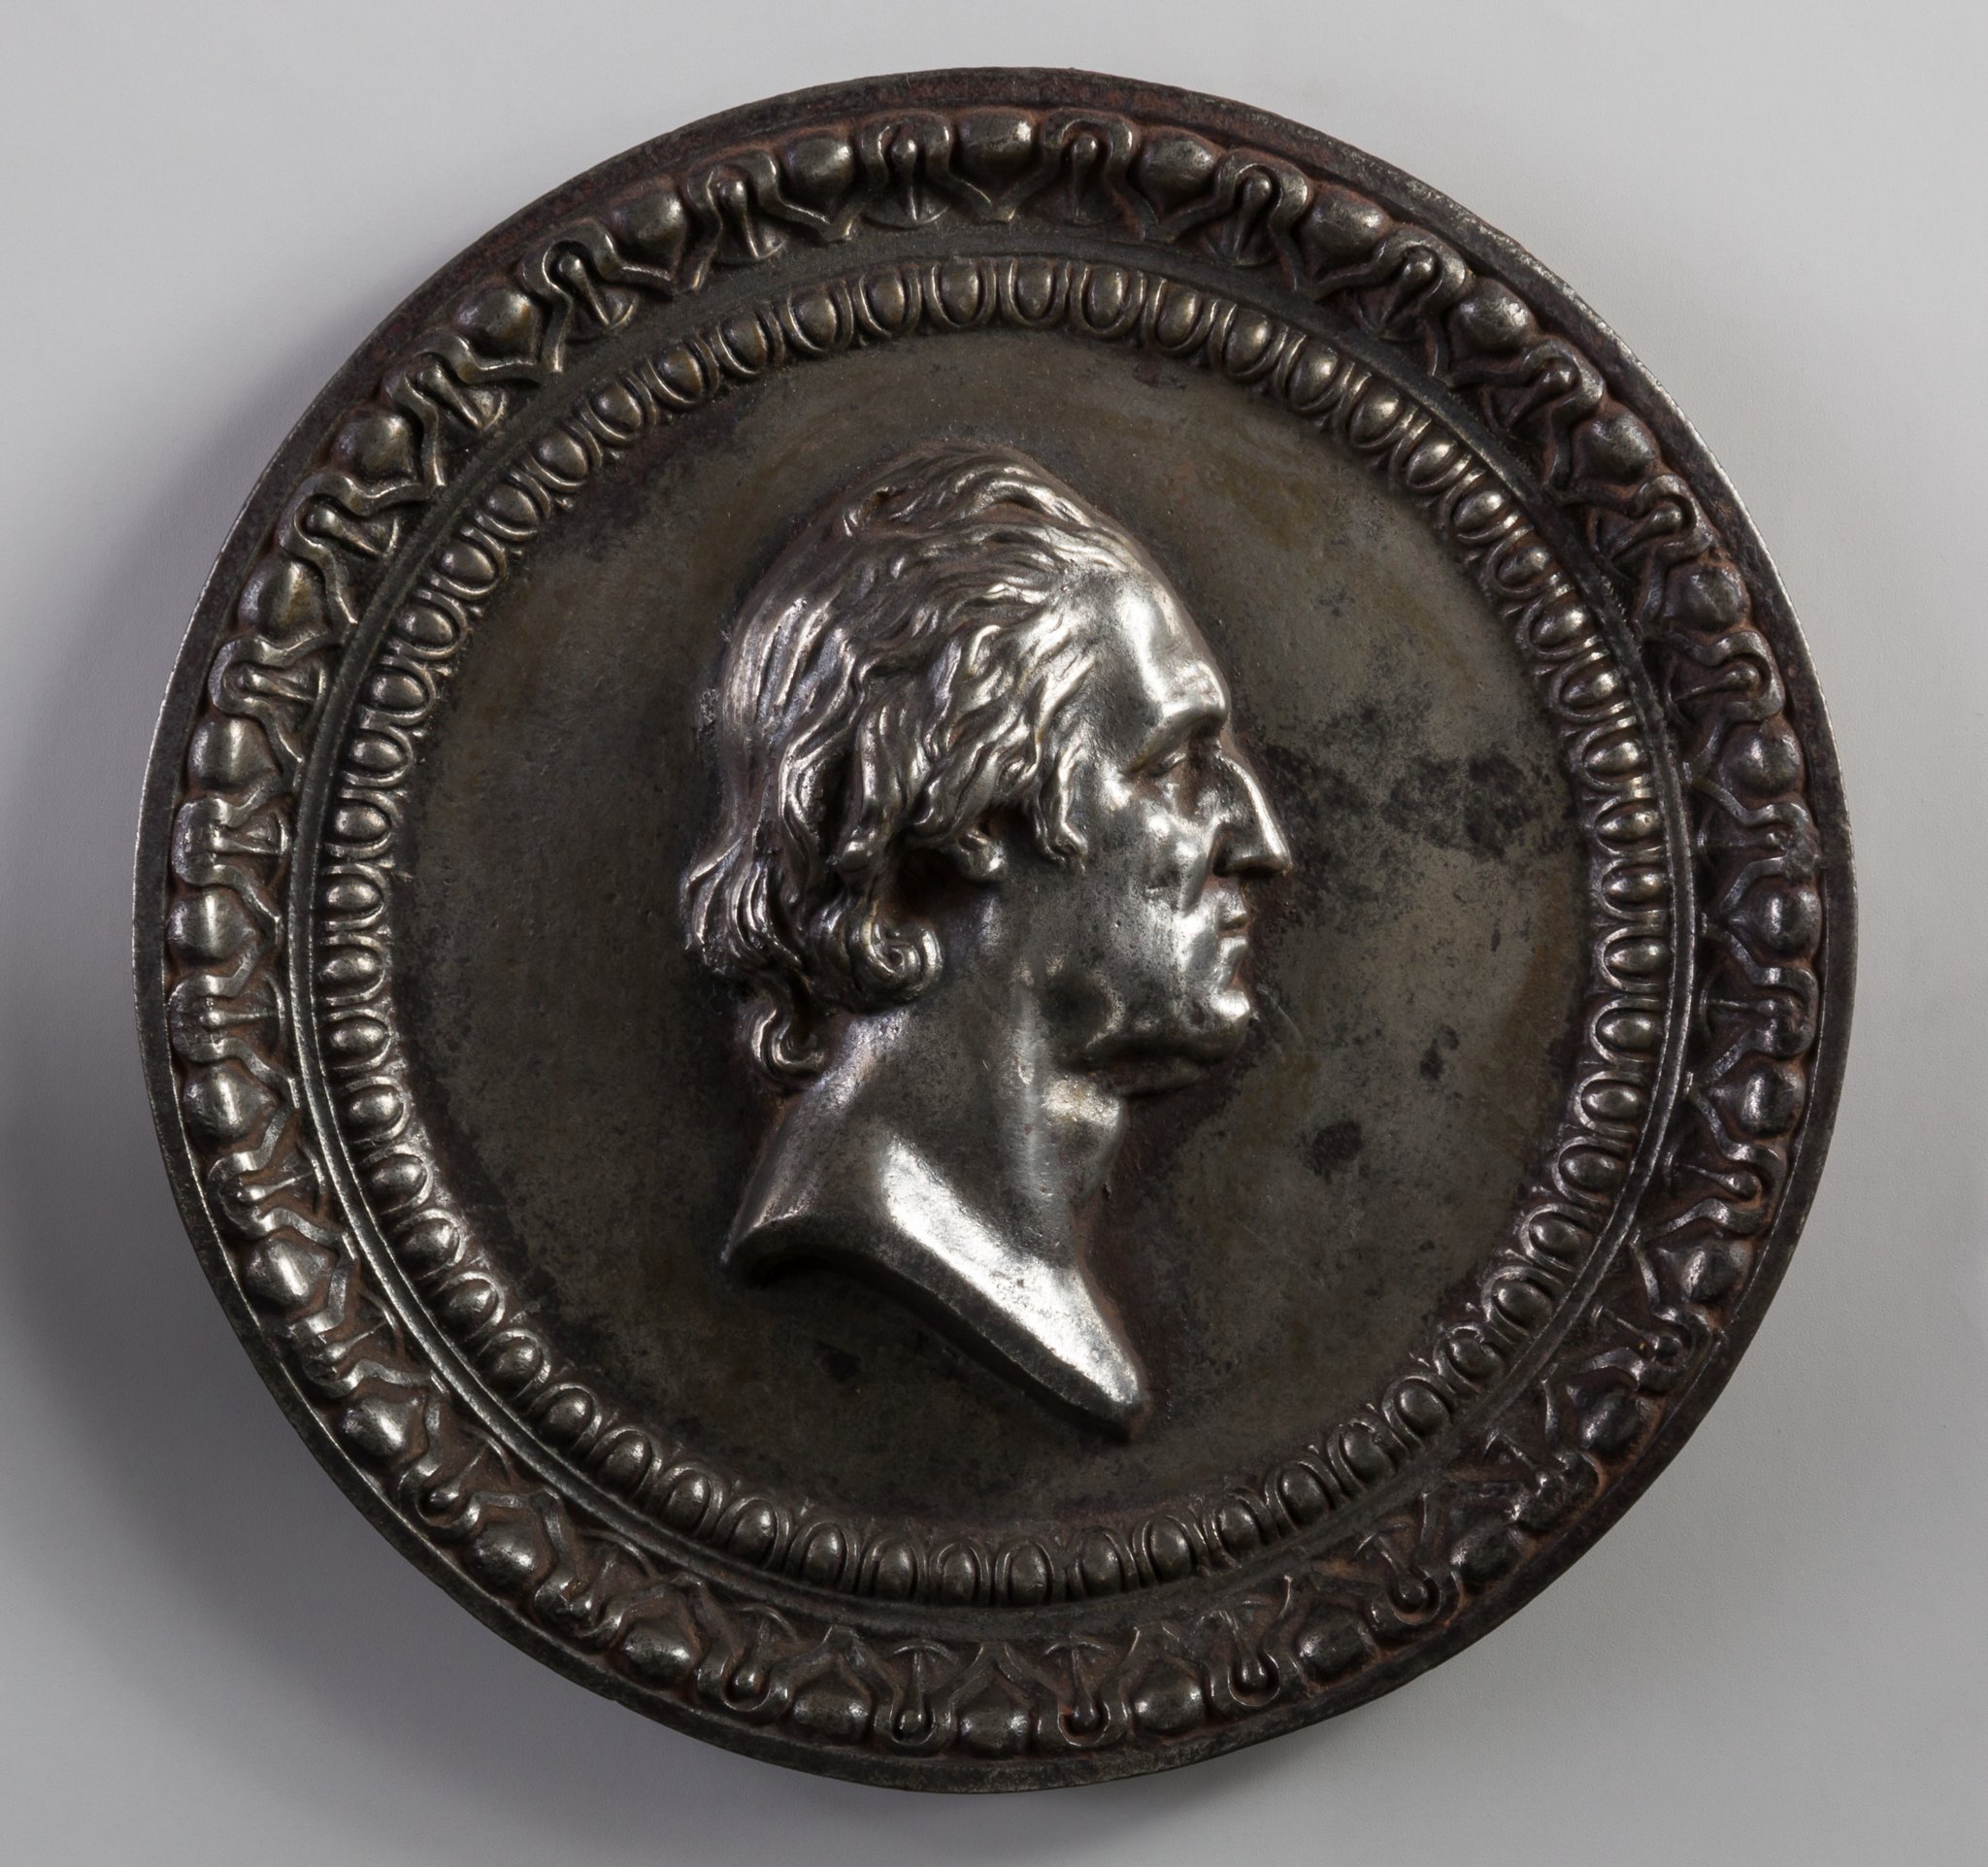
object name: plaque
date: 1776-1783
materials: iron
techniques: silvered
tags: men,profiles